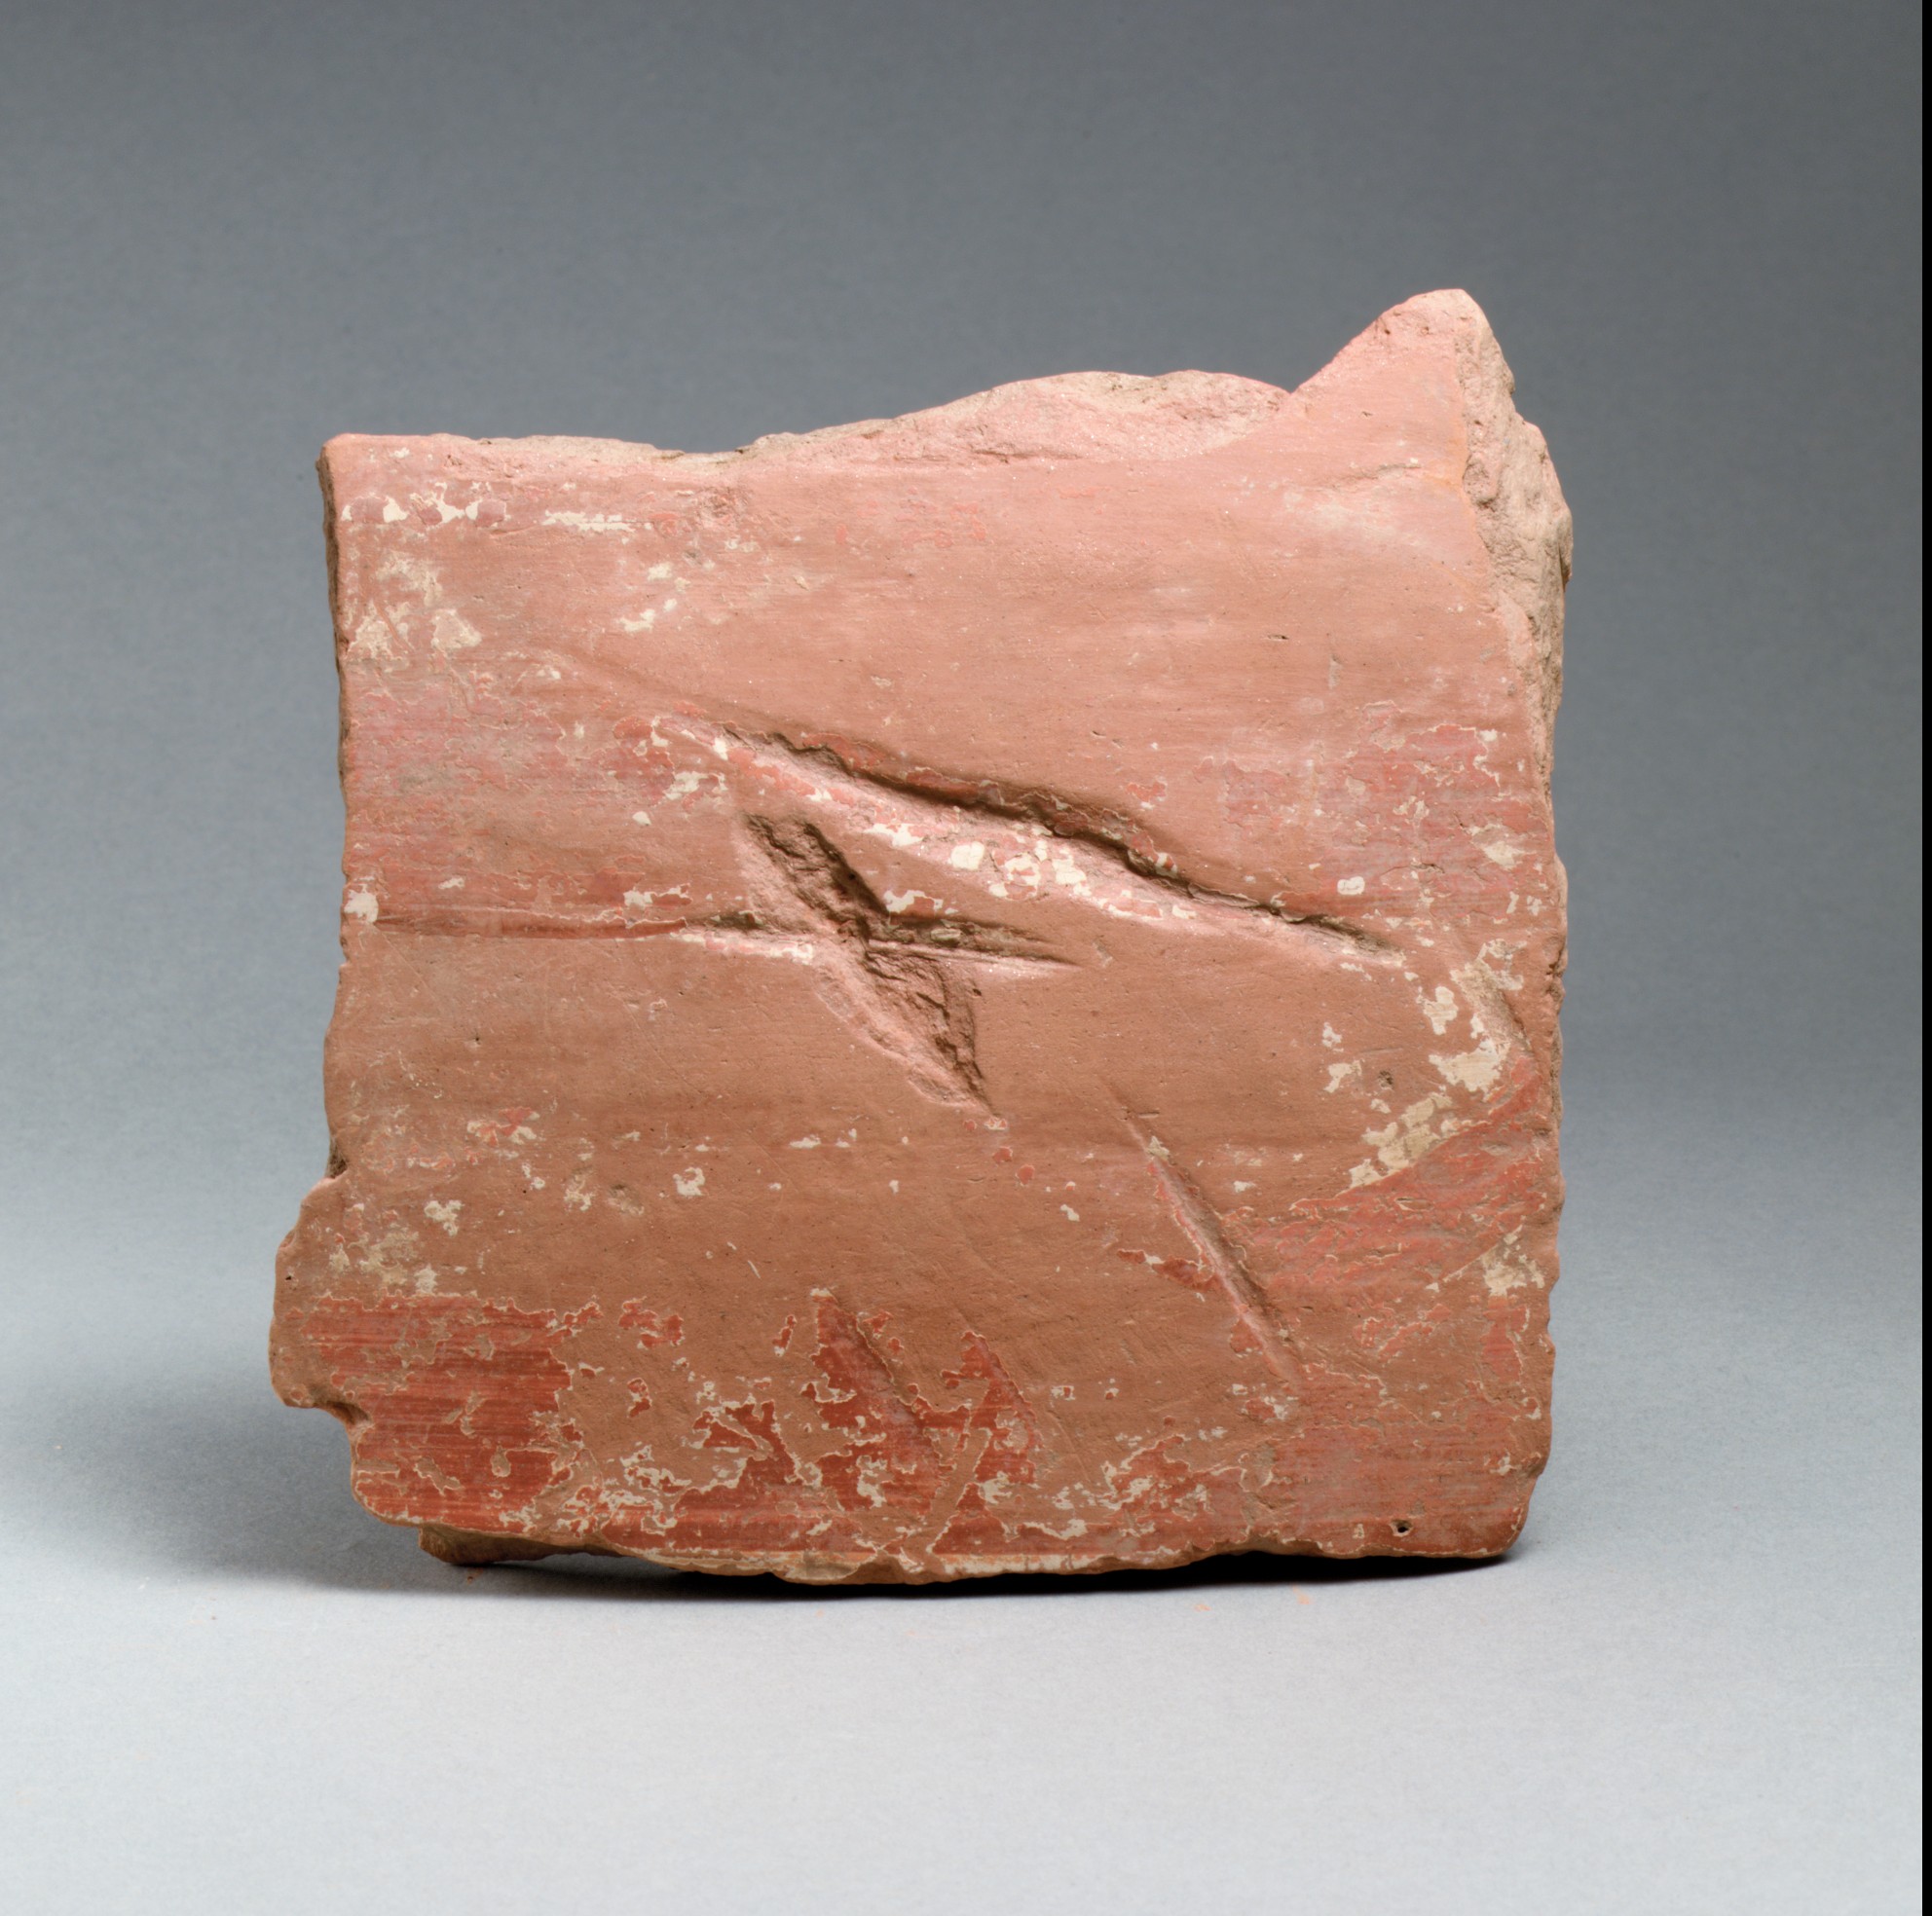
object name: vase fragment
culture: greek or lydian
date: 900-30 BCE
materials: terracotta